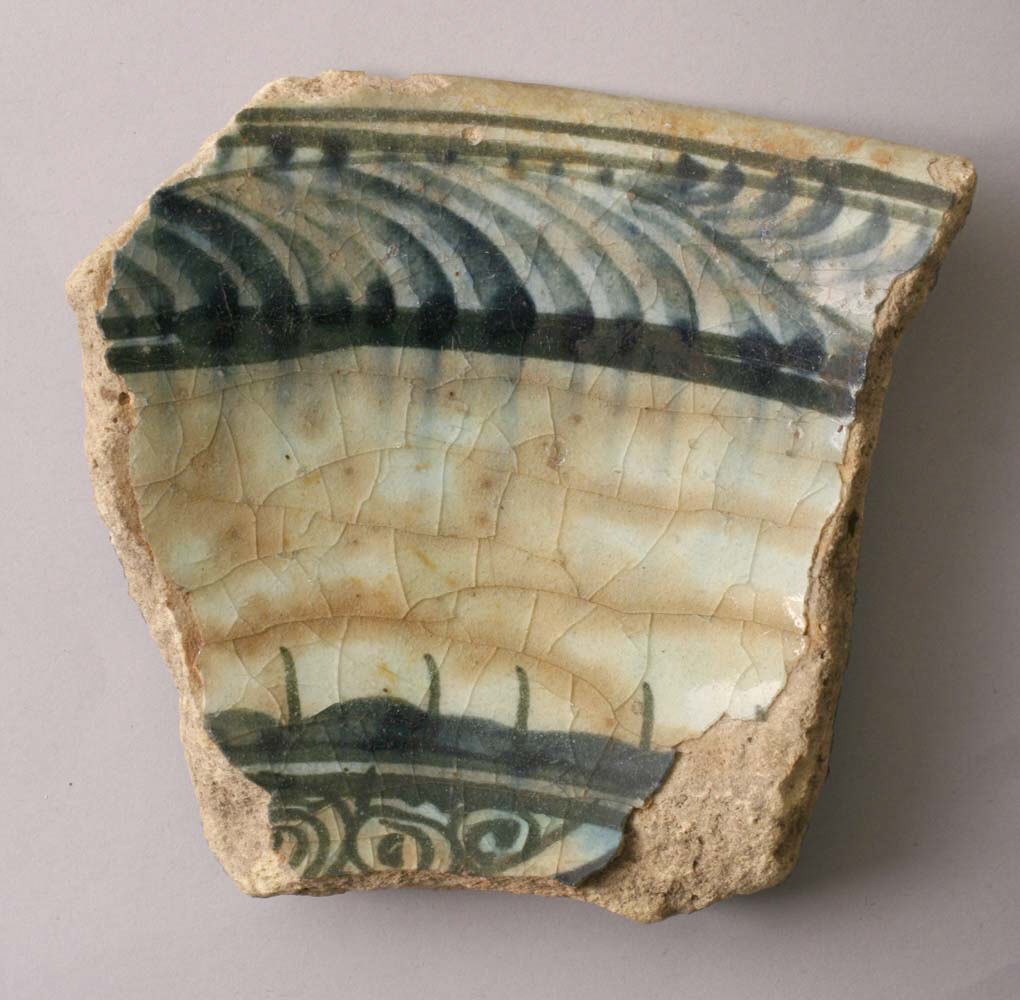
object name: fragment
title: Ceramic Fragment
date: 1301-1500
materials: glaze, stonepaste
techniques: painting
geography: egypt or syria